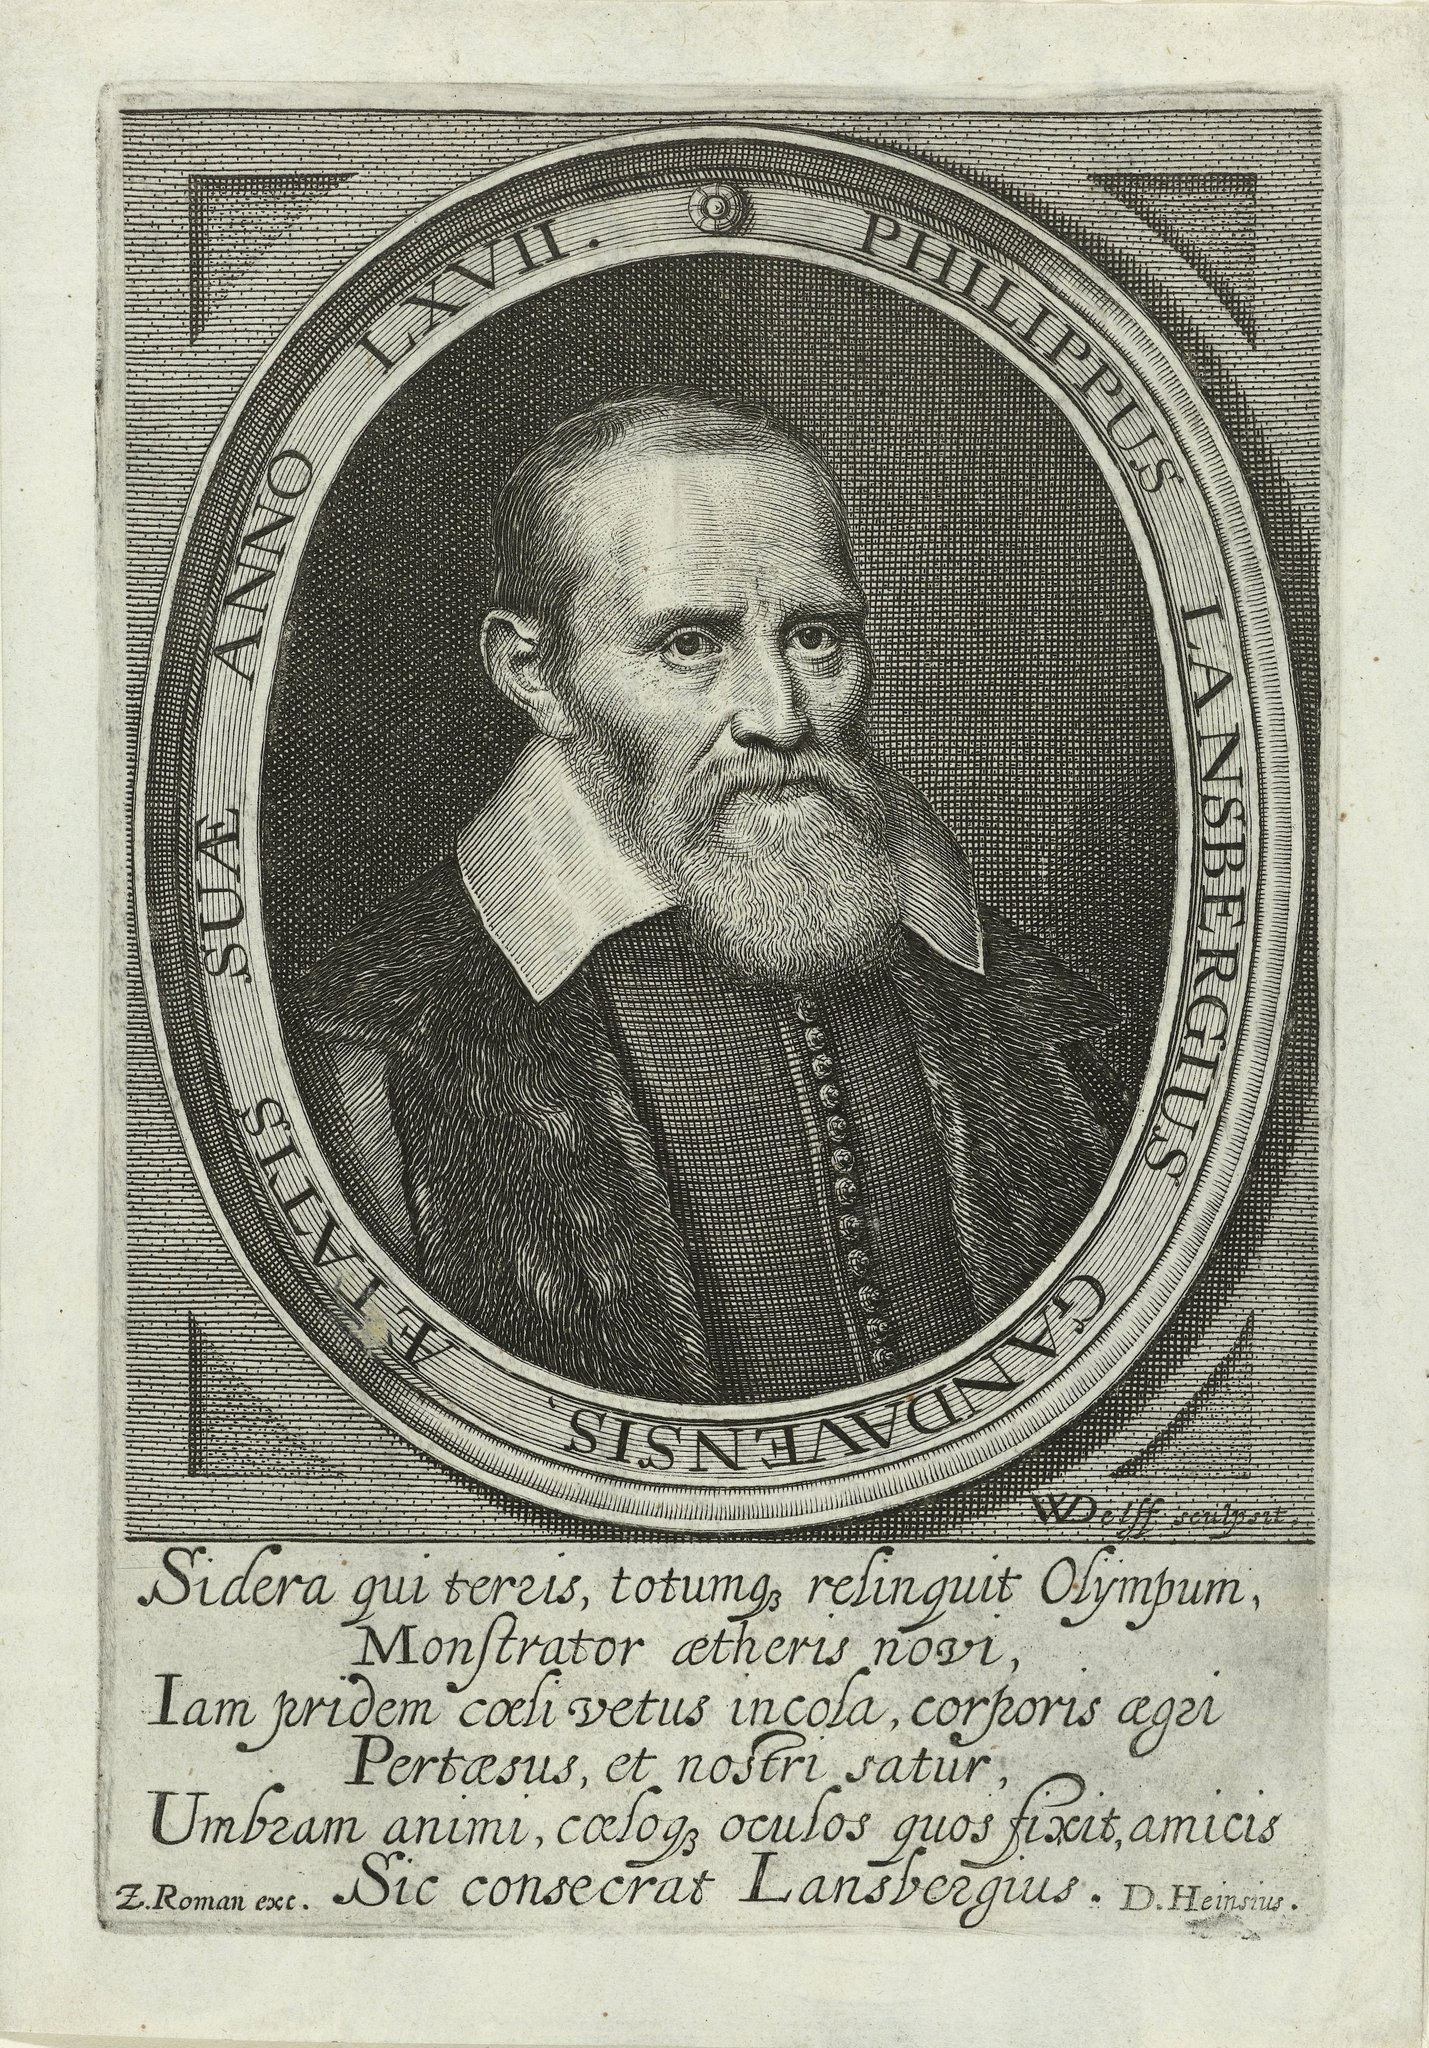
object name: print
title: Portret van Johan Philip Lansberge op 67-jarige leeftijd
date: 1628-1638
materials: paper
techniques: engraving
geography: middelburg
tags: ghent, middelburg, physicist, philippus lansbergen, portrait of a writer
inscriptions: collector's mark: Lugt 2228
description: Prent uit: Philippi Lansbergii, astronomi celeberrimi, opera omnia, Middelburg, Zacharias Roman (uitgever), 1663, zie titel op verso. Deze titel wijkt af van de Nederlandse titel genoemd in Hollstein, het betreft een vroegere uitgave dan de beschreven staat uit 1666.